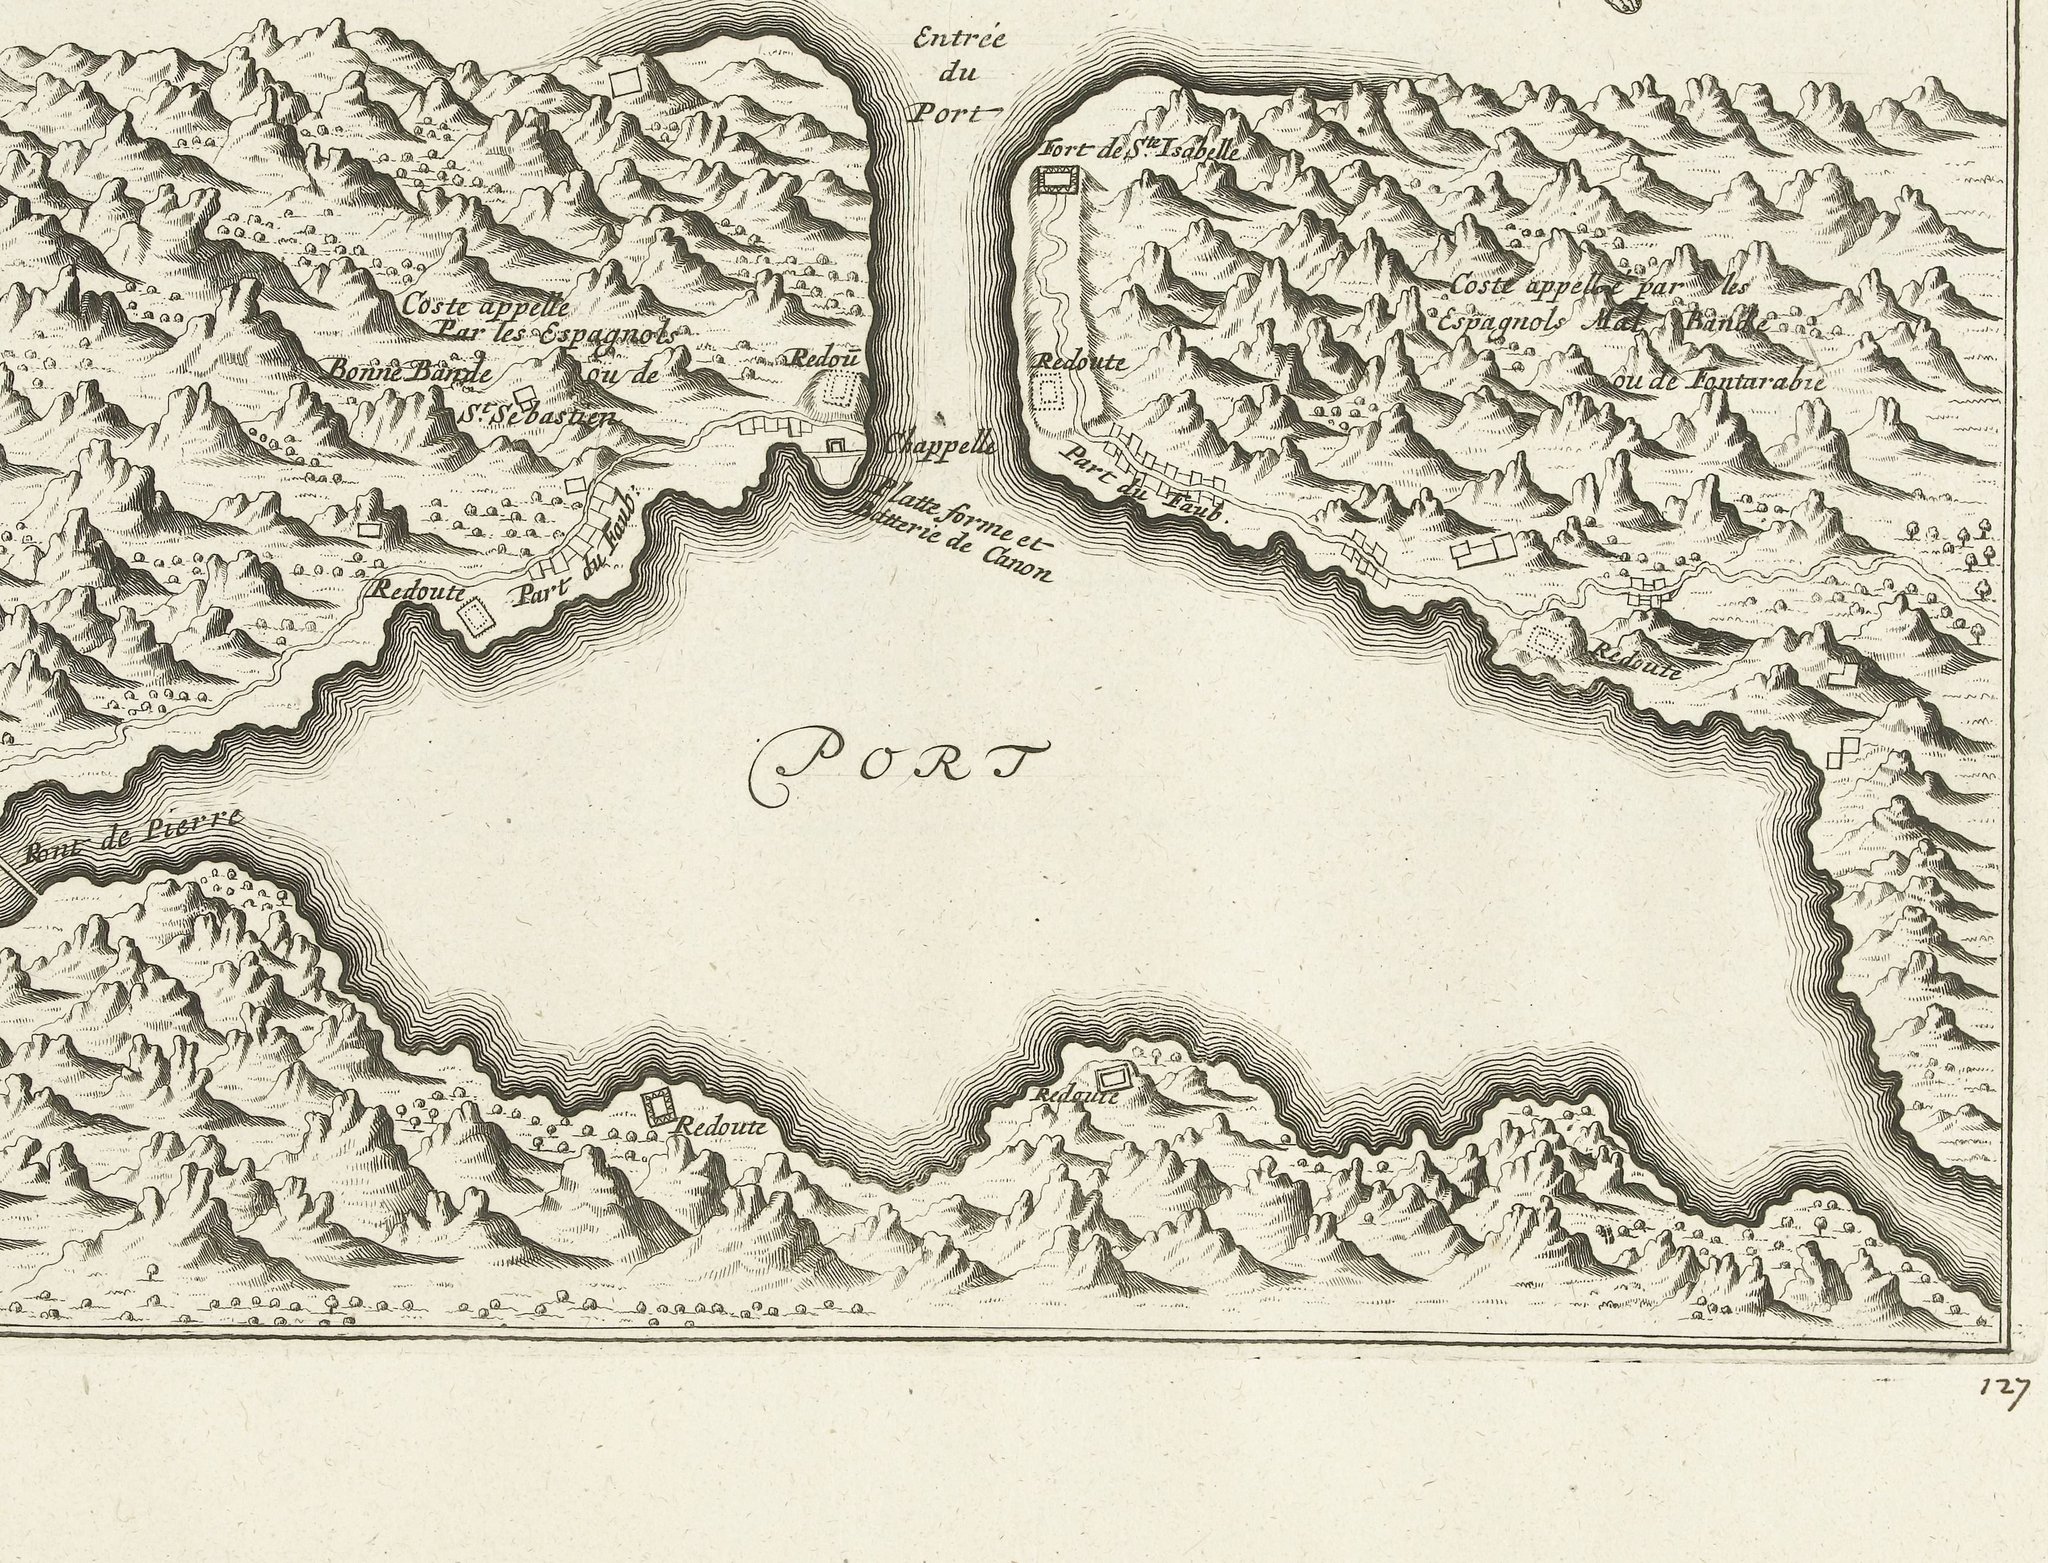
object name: print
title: Kaart van de natuurlijke haven van Puerto de Pasajes, 1726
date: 1726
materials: paper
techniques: etching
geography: northern netherlands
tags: maps of separate countries or regions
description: Kaart van de natuurlijke haven van Puerto de Pasajes aan de Spaanse Noordkust bij San Sebastian. Plaat nr. 127 in deel VI van het prentwerk: Les Forces de l'Europe, Asie, Afrique et Amerique ... Comme aussi les Cartes des Côtes de France et d'Espagne uit 1726, dit eerste deel met 238 met de hand genummerde platen van vermaarde sterke steden en vestingen in het kader van de Spaanse Successieoorlog 1701-1713. Voor het merendeel zijn deze platen gekopieerd naar de anonieme Franse platen van vermaarde sterke steden en vestingen: in Les forces de l'Europe en in: Le theatre de la guerre, dans les Pays-Bas, beide oorspronkelijk uitgegeven door Nicolas de Fer te Parijs (1693-1697) in het kader van de Negenjarige Oorlog. Titel en opschriften in het Frans.